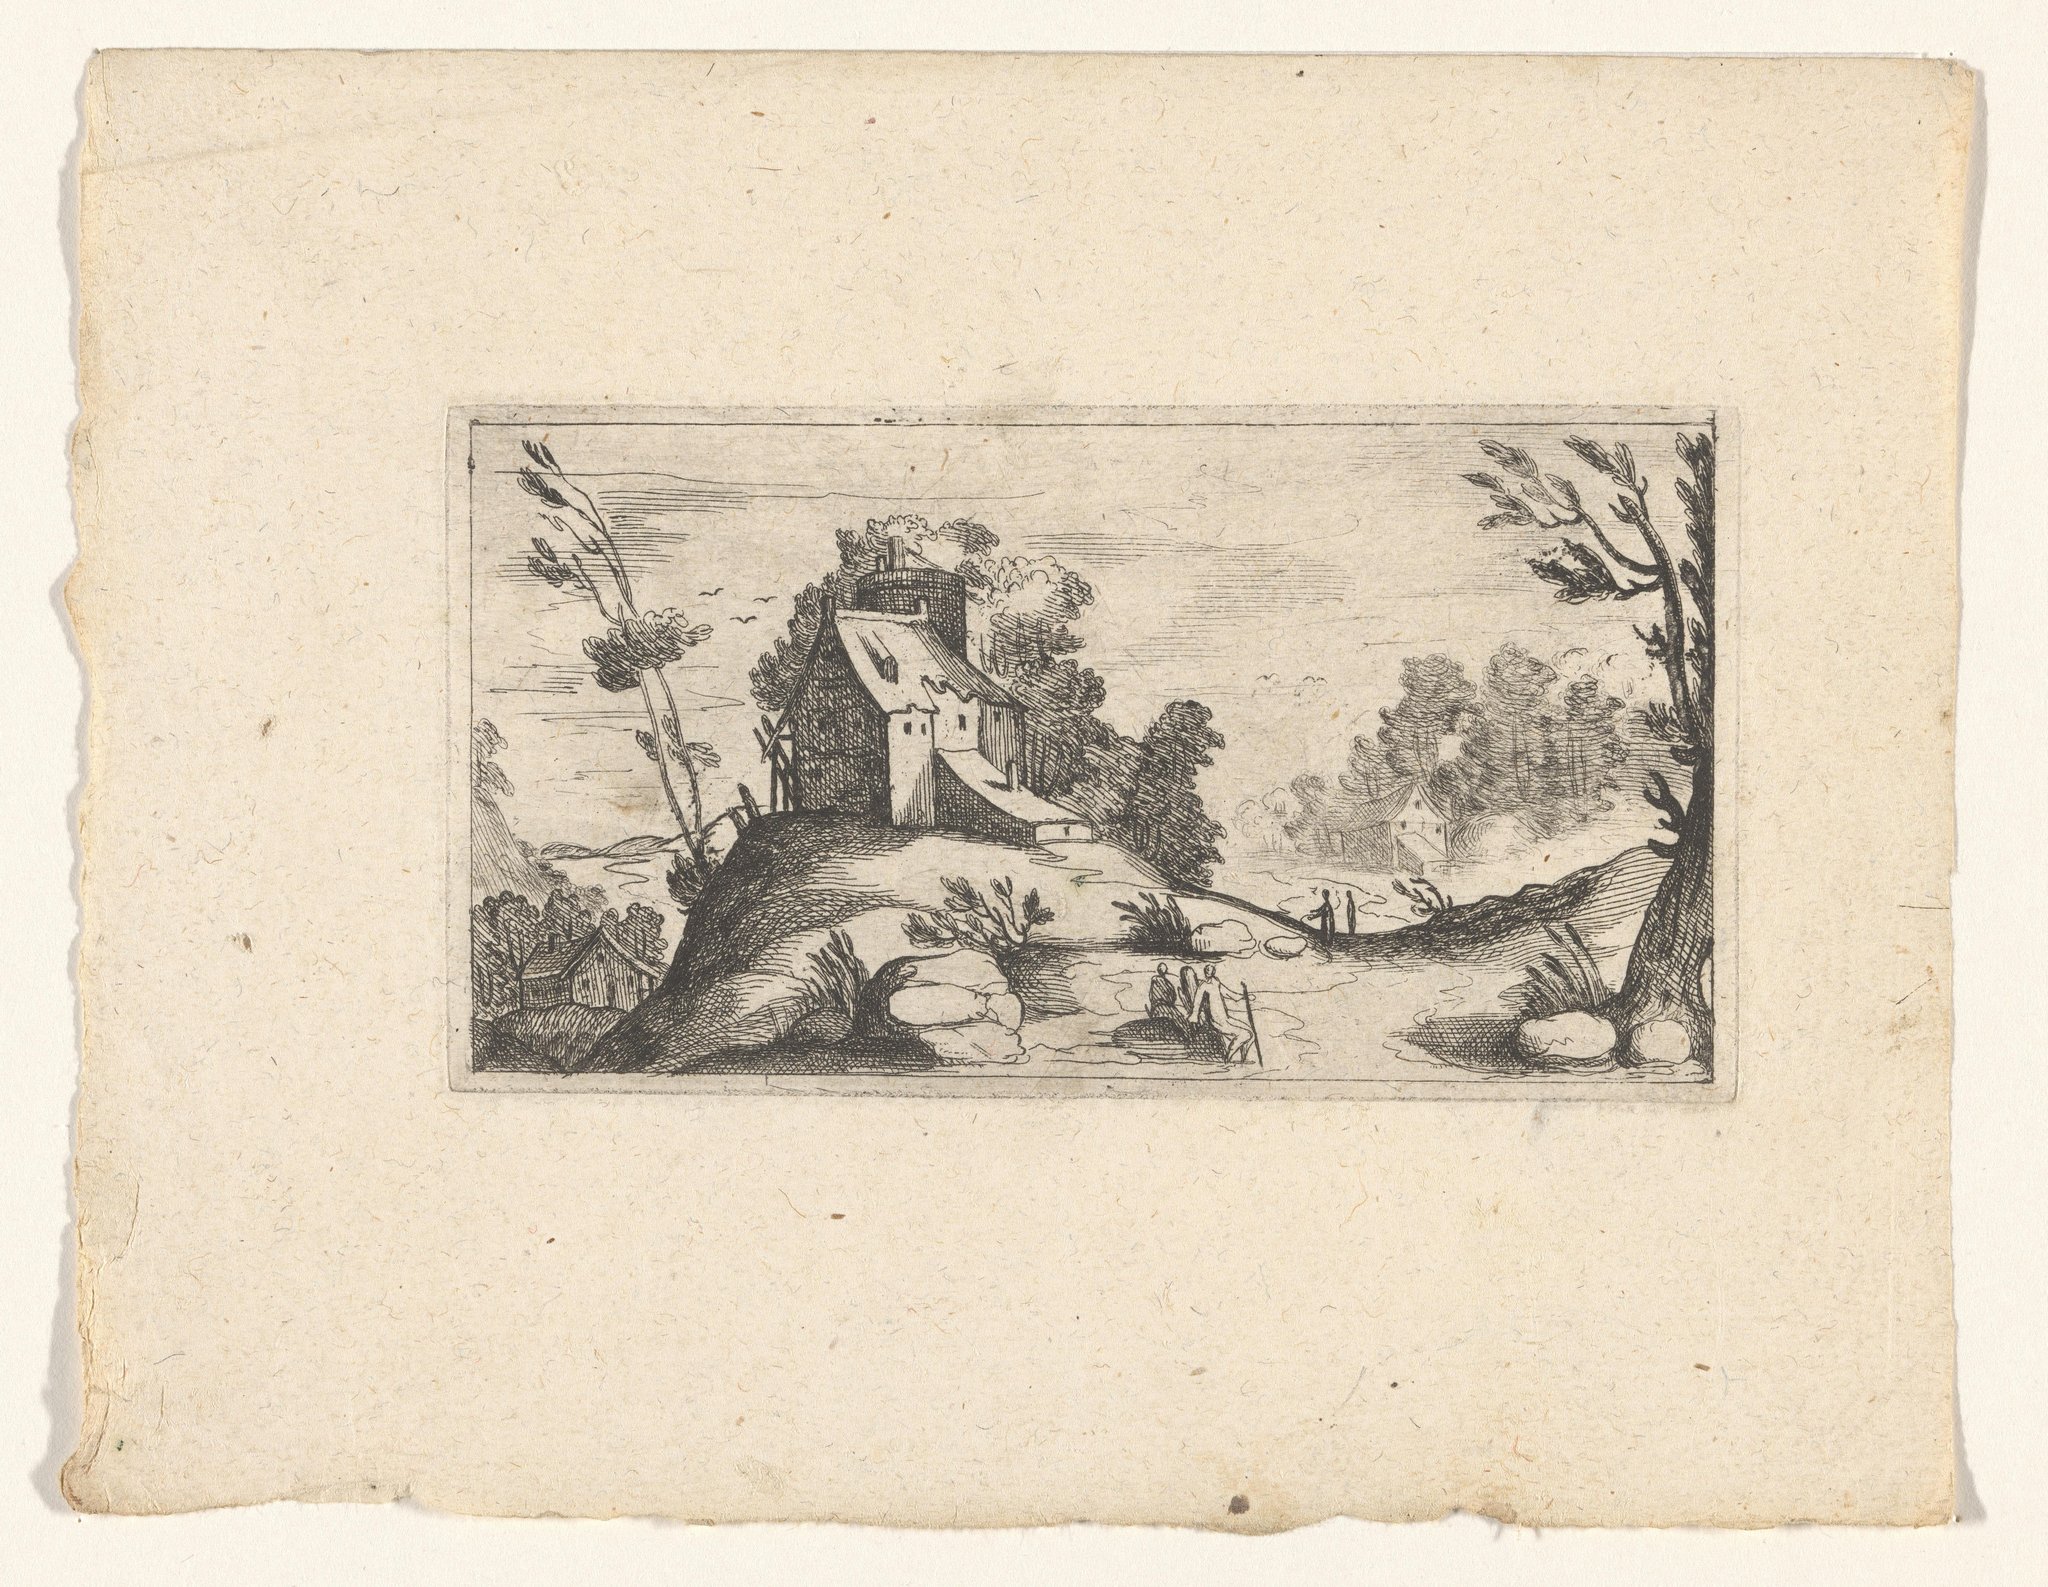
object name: print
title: Landschap met huis op een heuvel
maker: Anonymous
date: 1550-1650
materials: ink, paper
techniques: etching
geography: europe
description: De H. Elizabeth van Hongarije draagt een kroon op haar hoofd en in haar linkerhand een boek met daarop twee kronen. Met haar rechterhand geeft zij een aalmoes aan een jonge bedelaar.